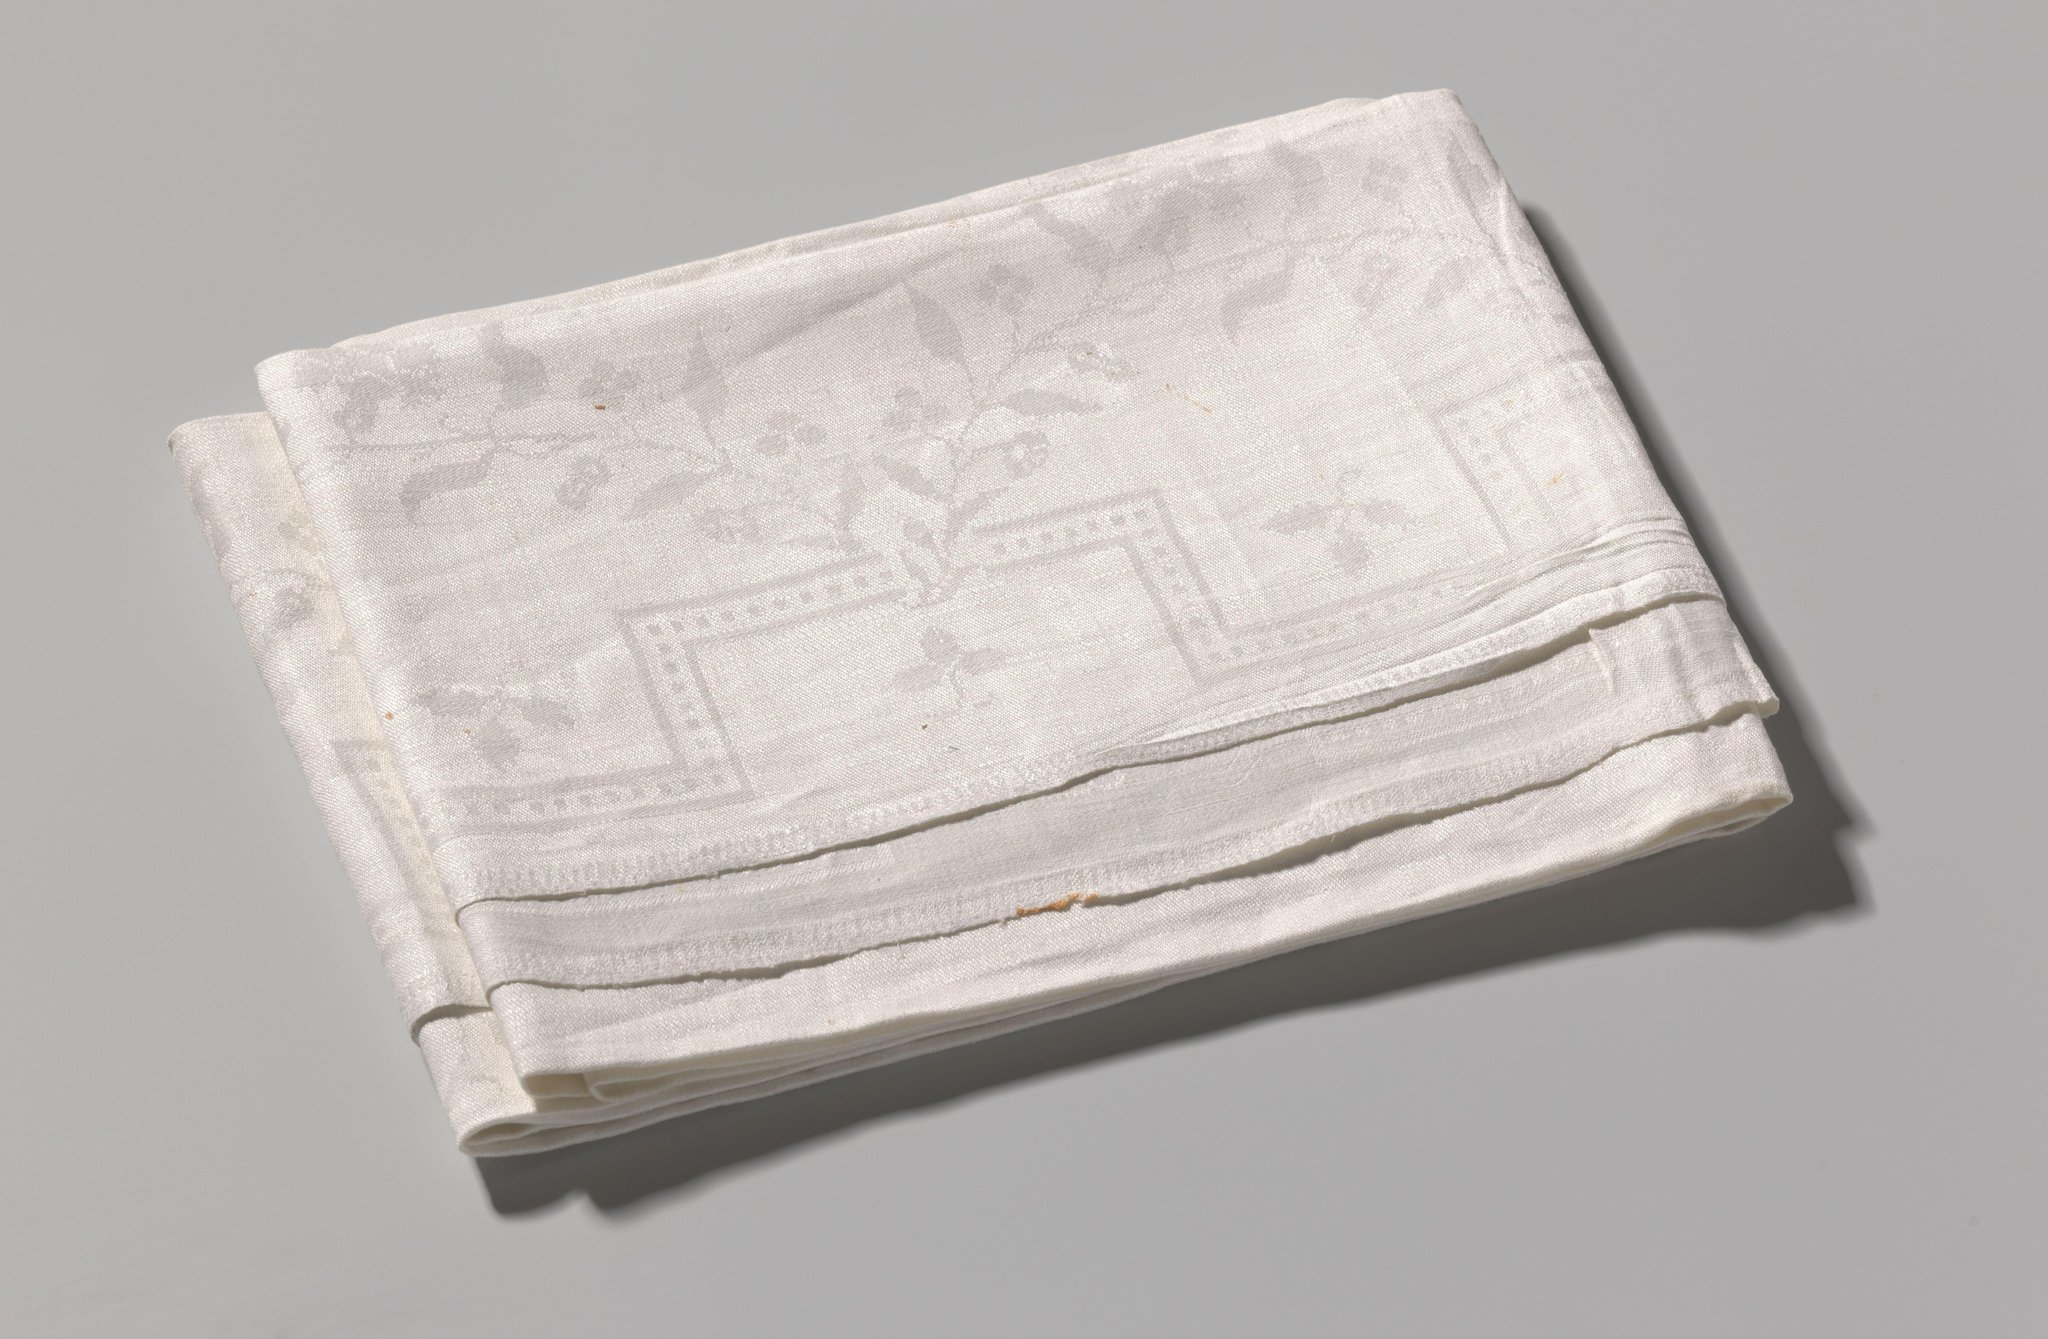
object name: runner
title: Dwaal of loper van linnendamast met wapens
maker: Anonymous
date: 1803-1825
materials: linen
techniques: damask, weave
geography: low countries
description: Dwaal of loper van linnendamast met in de hoeken de wapens van d'Achard. De dwaal hoort bij een tafellaken (BK-1971-245) en twee servetten (BK-1971-244-A en BK-1971-244-B).